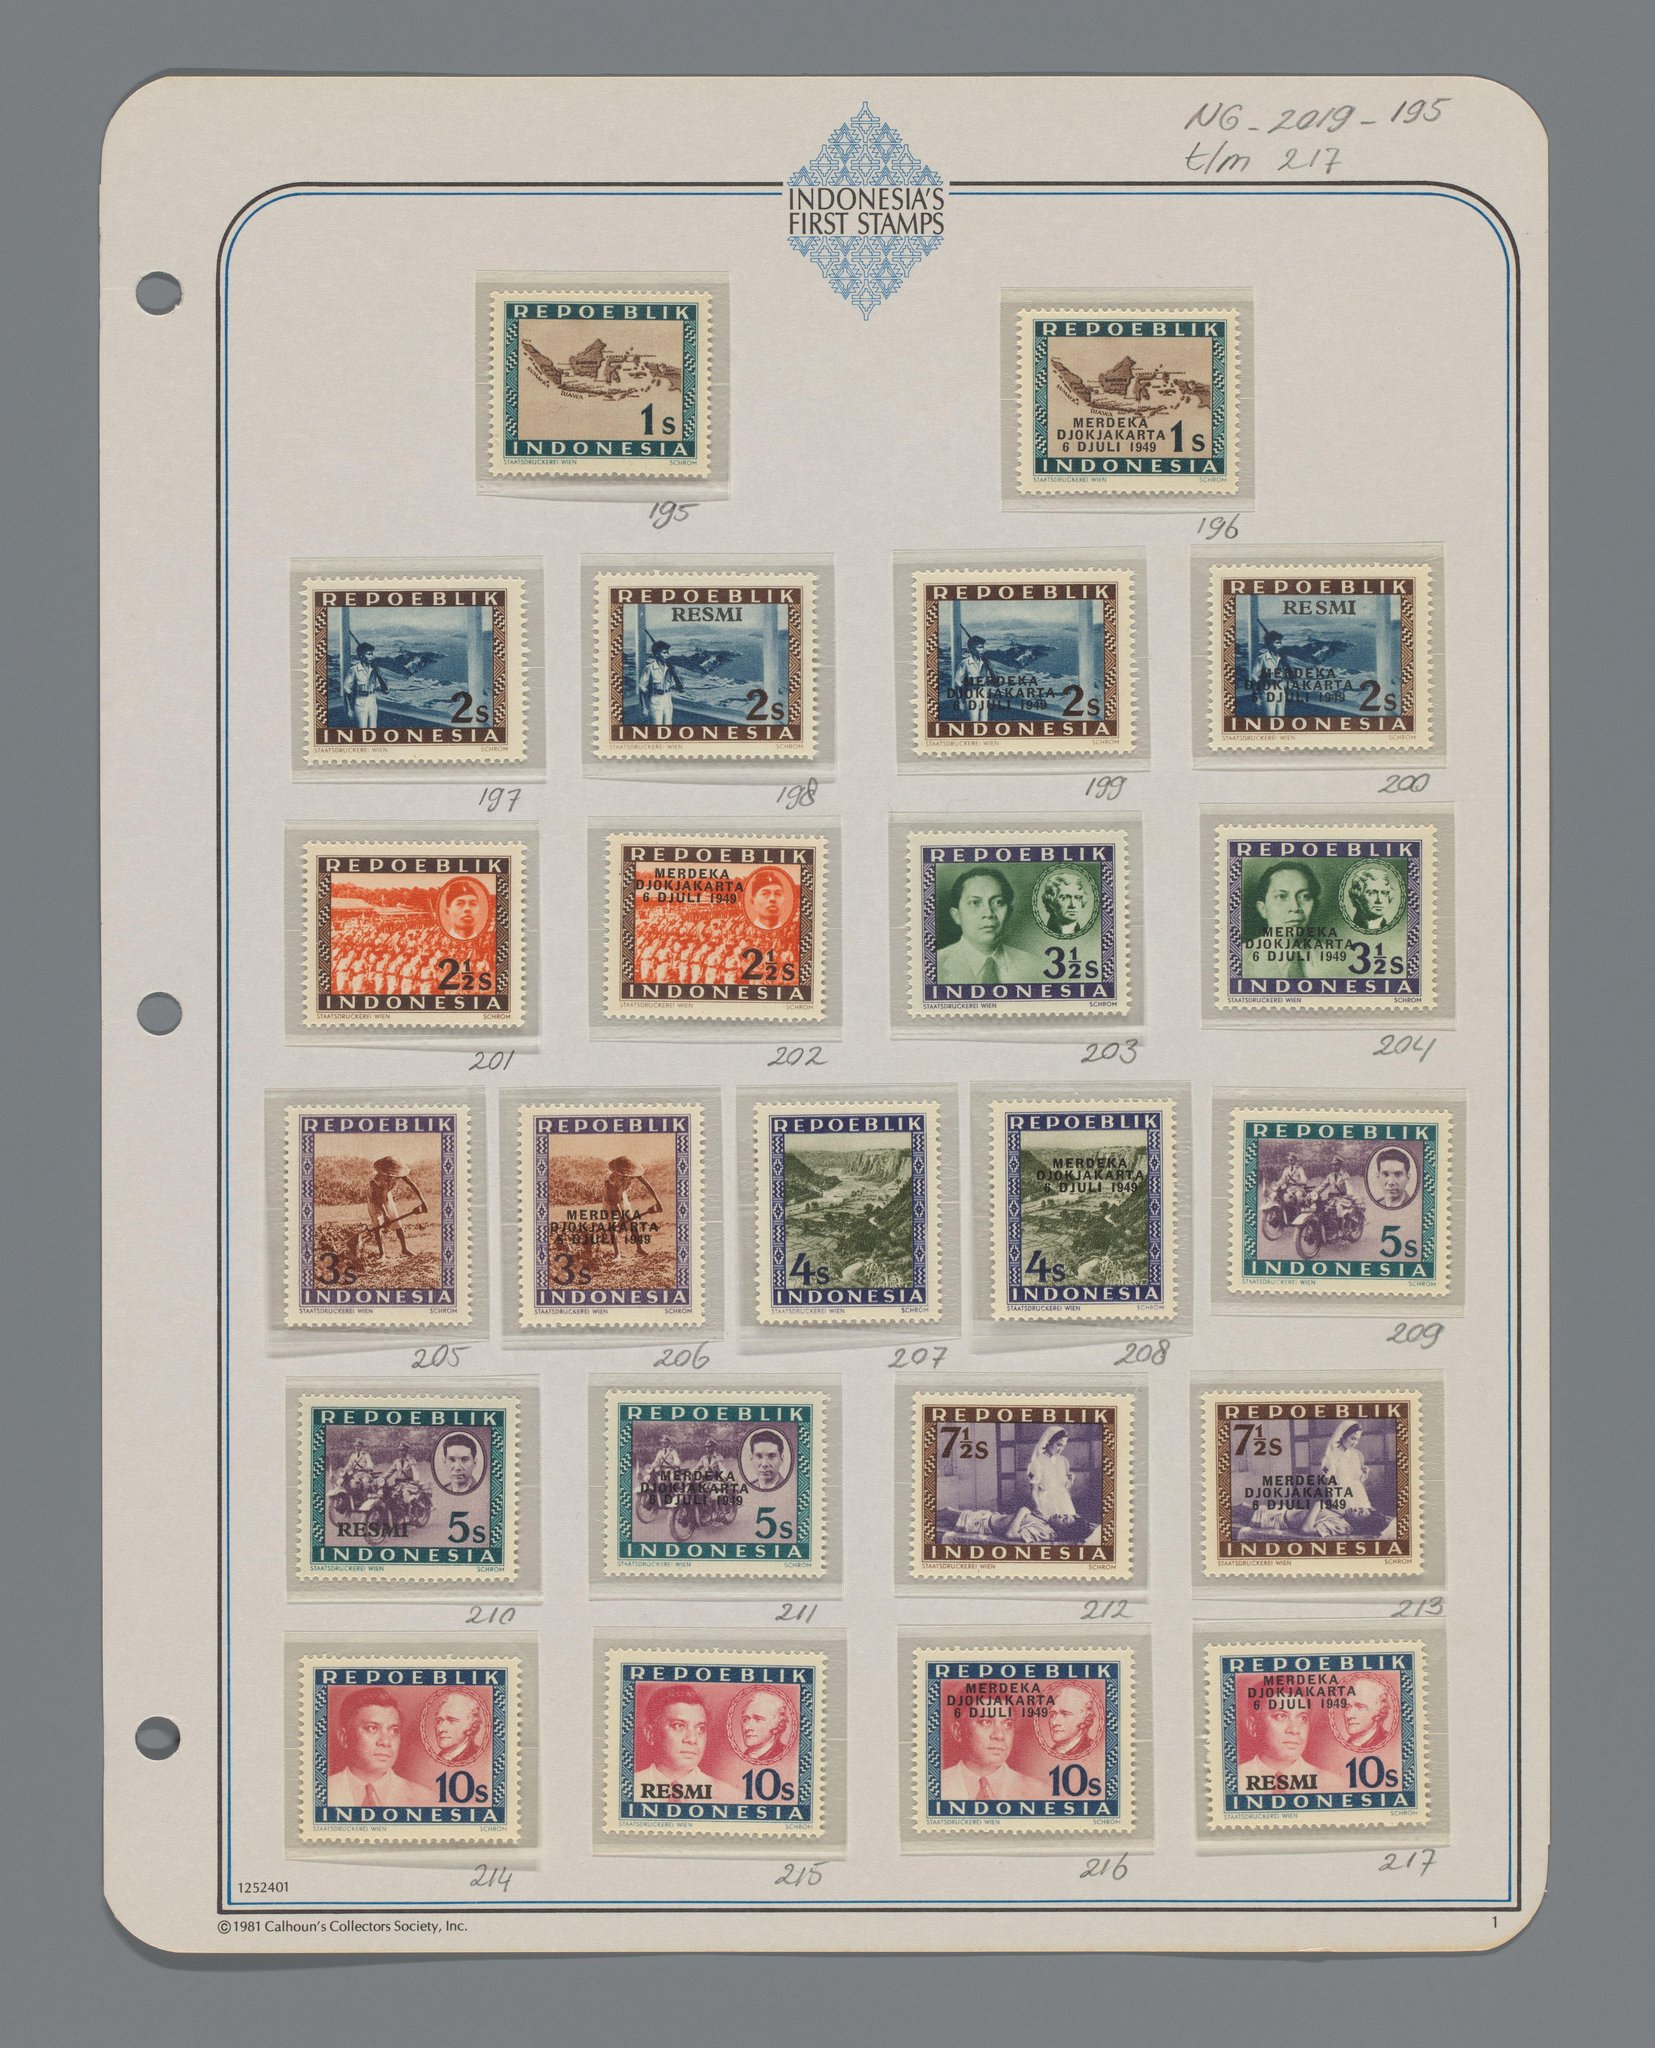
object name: postage stamp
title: Postzegel Republik Indonesia 1s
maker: ernst schrom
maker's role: painter, print maker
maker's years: 1902-1969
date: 1949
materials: paper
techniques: photoaquatint, engraving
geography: vienna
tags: indonesia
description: Postzegel met topografische kaart van Indonesië met opdruk "MERDEKA DJOKJAKARTA 6 DJULI 1949"